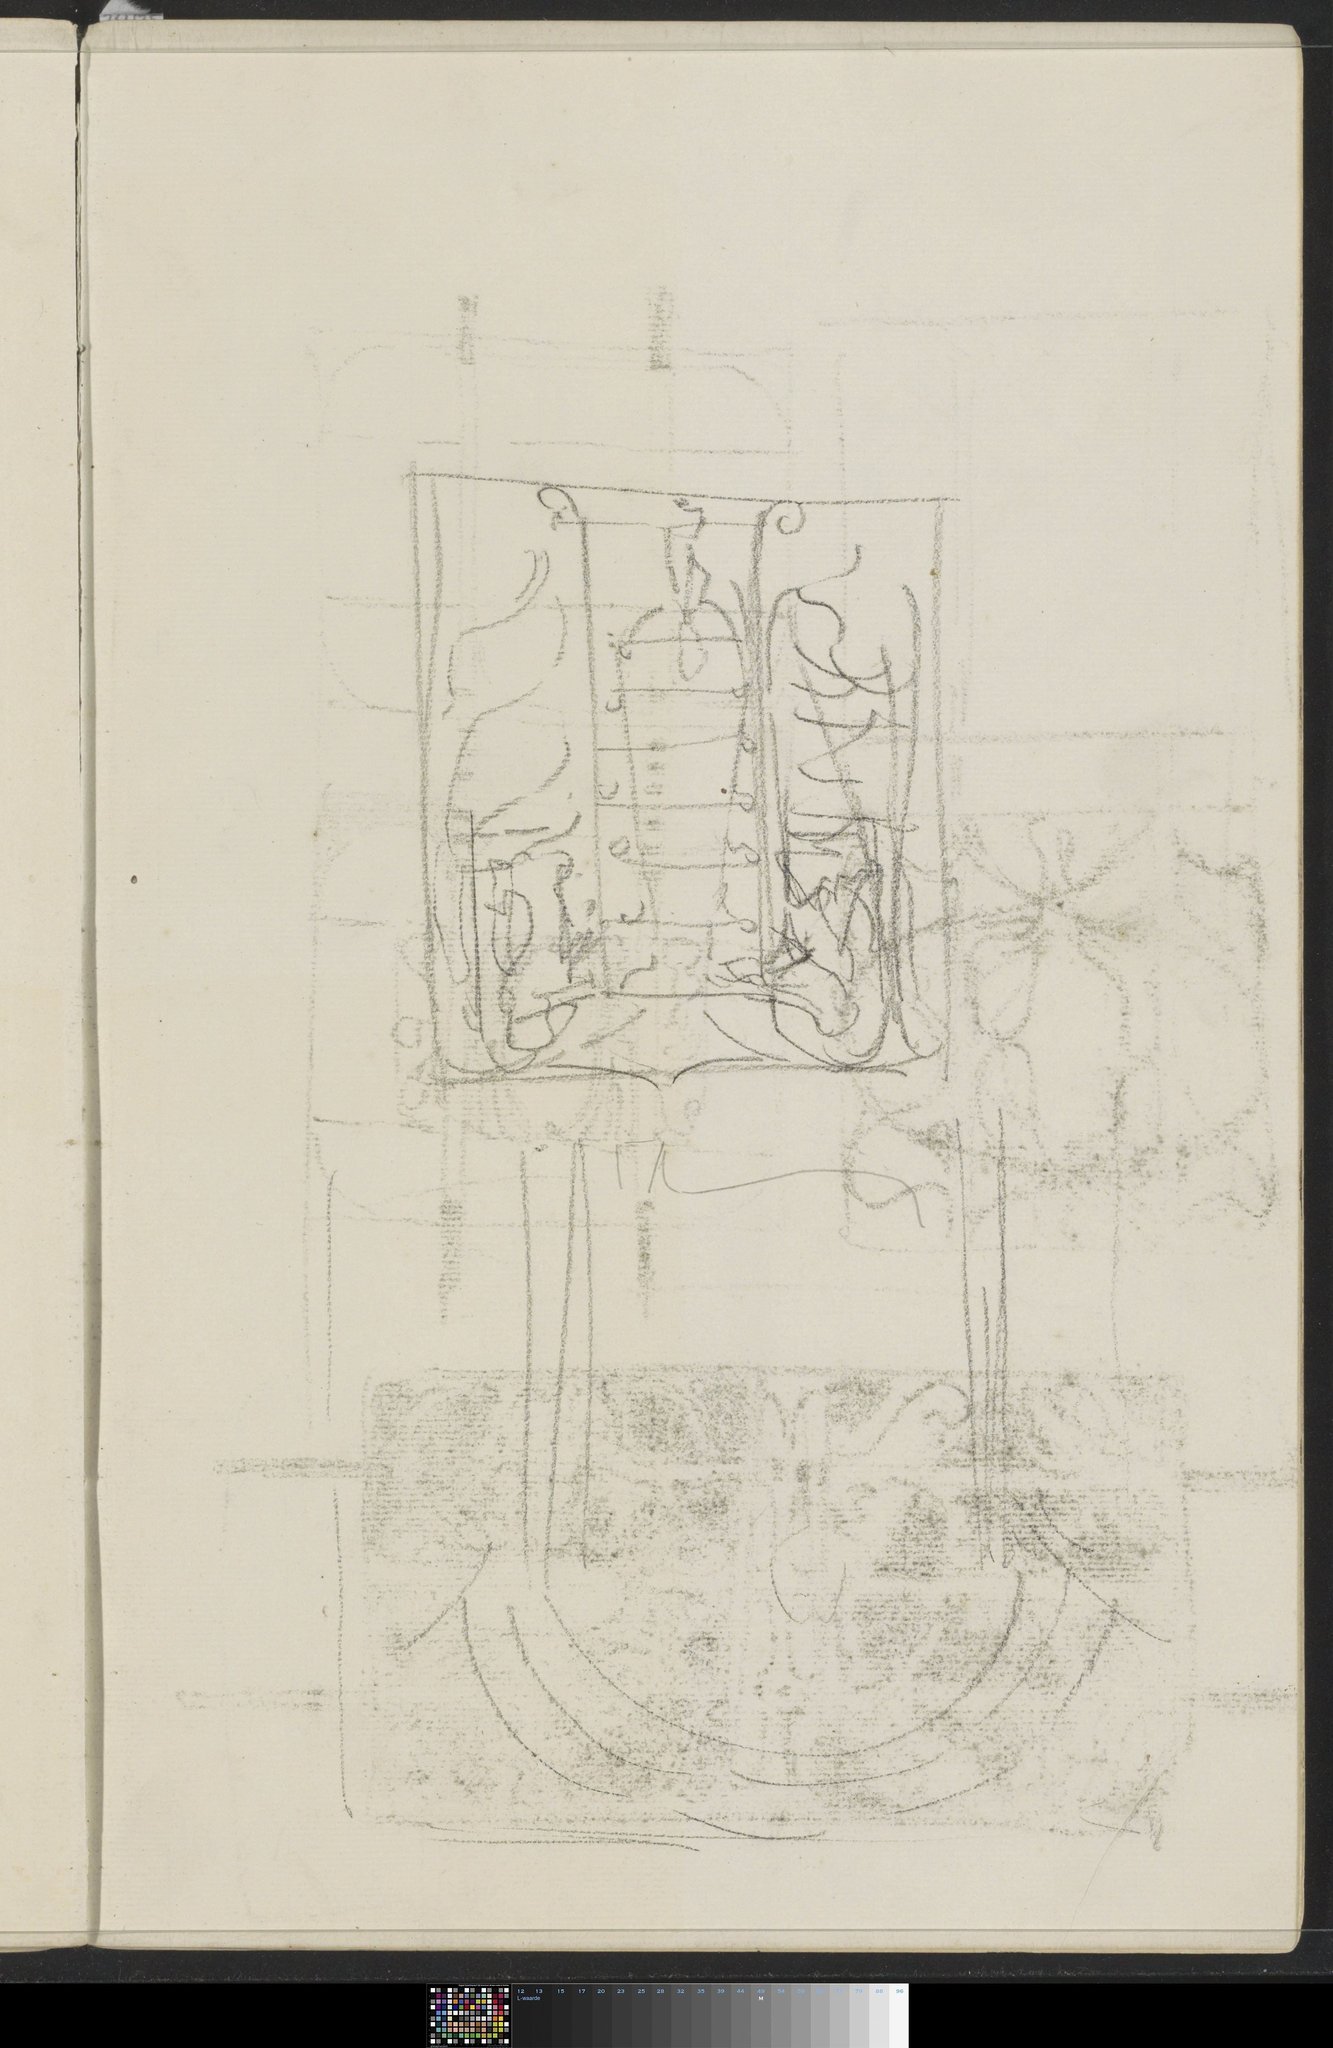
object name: sketchbook leaf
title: Boog en een ontwerp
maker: carel adolph lion cachet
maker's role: draughtsman, print maker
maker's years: 1864-1945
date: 1897-1898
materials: chalk, paper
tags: architecture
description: Blad 23 recto uit een schetsboek met 29 bladen.